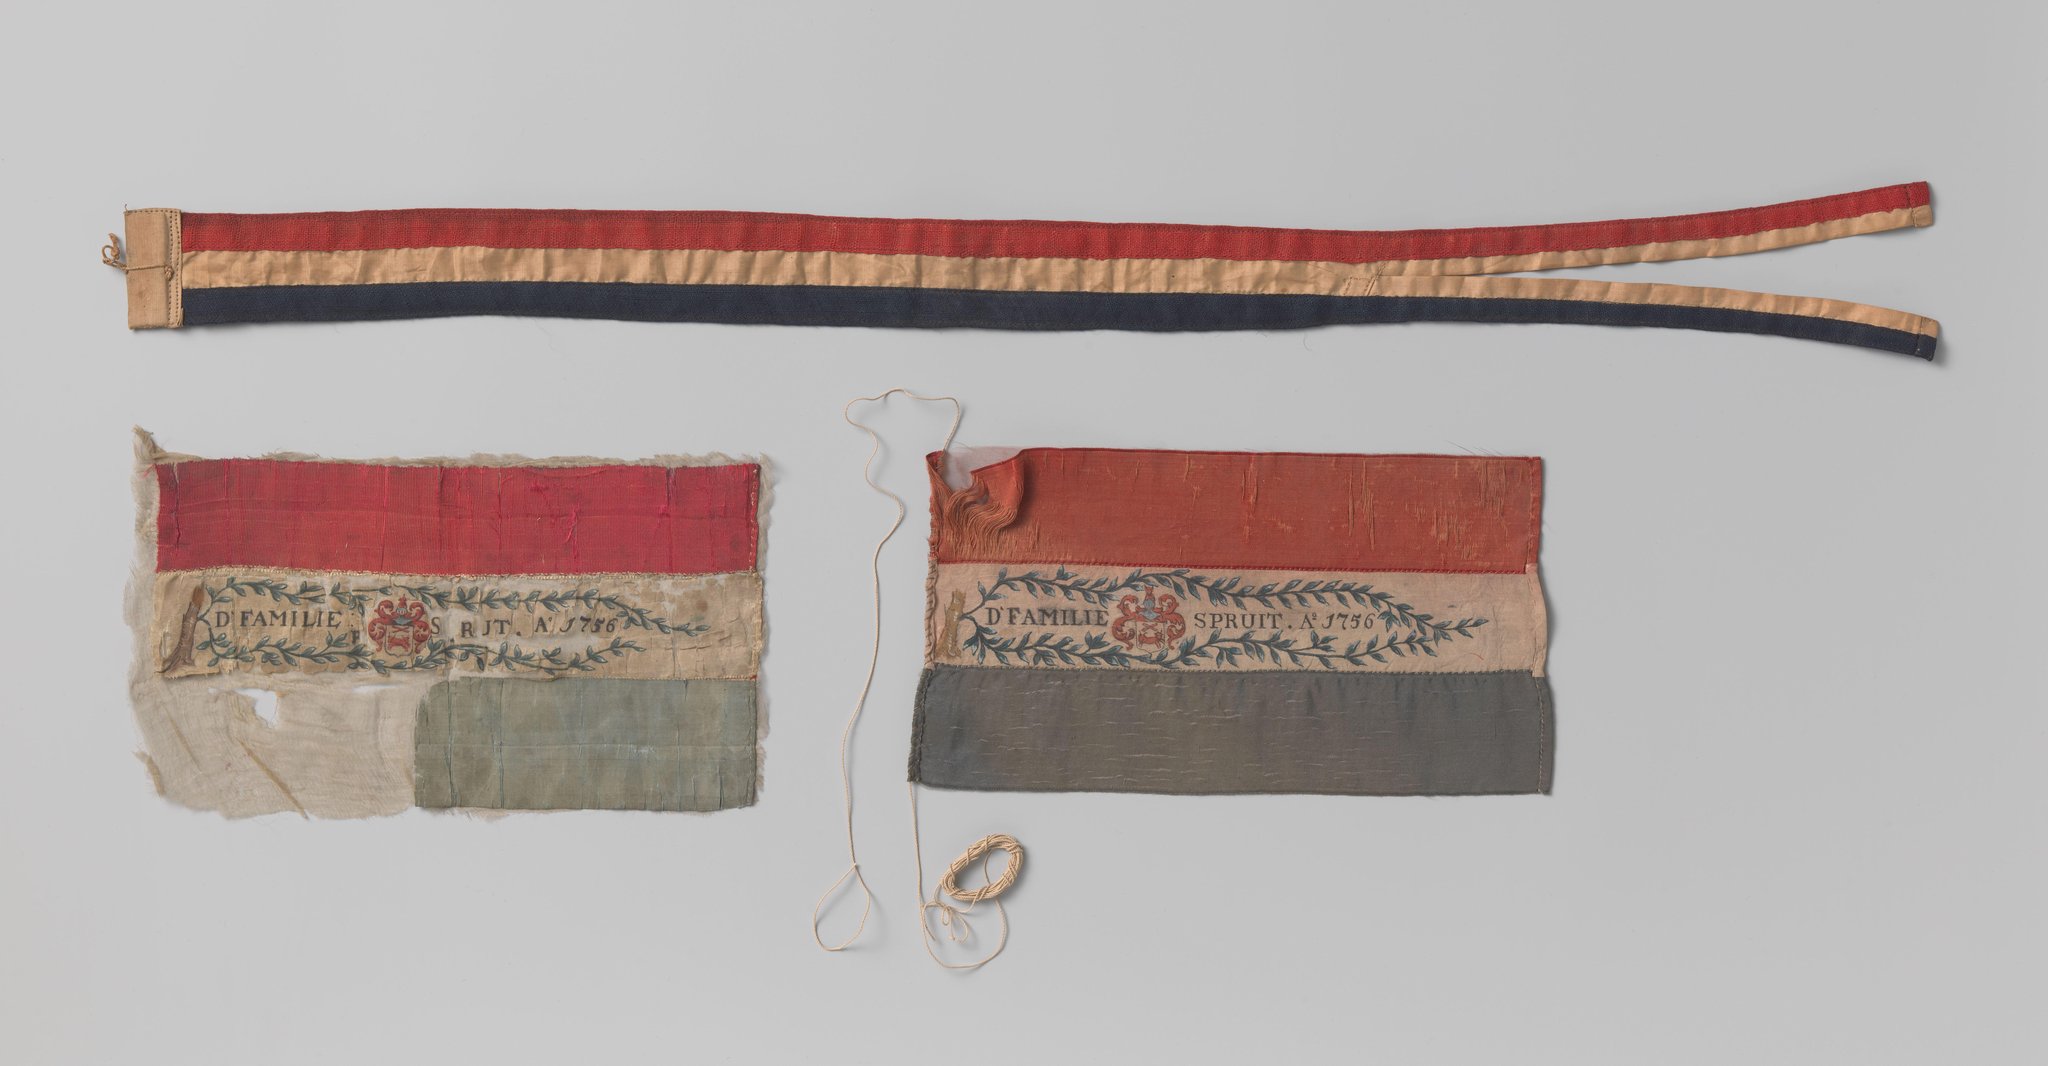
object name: part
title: Twee vlaggen en een wimpel van het scheepsmodel van een hoeker van de familie Spruit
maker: Anonymous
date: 1756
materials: linen, silk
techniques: printing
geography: netherlands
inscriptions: inscription: ‘D'FAMILIE [familiewapen] SPRUIT Aº 1756’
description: Op de twee driekleurige vlaggen staat het opschrift: D' FAMILIE [familiewapen] SPRUIT Aº 1756. Ook de wimpel is rood-wit-blauw gekleurd. De vlaggen horen bij het scheepsmodel van een hoeker van de familie Spruit (NG-NM-12047-A).